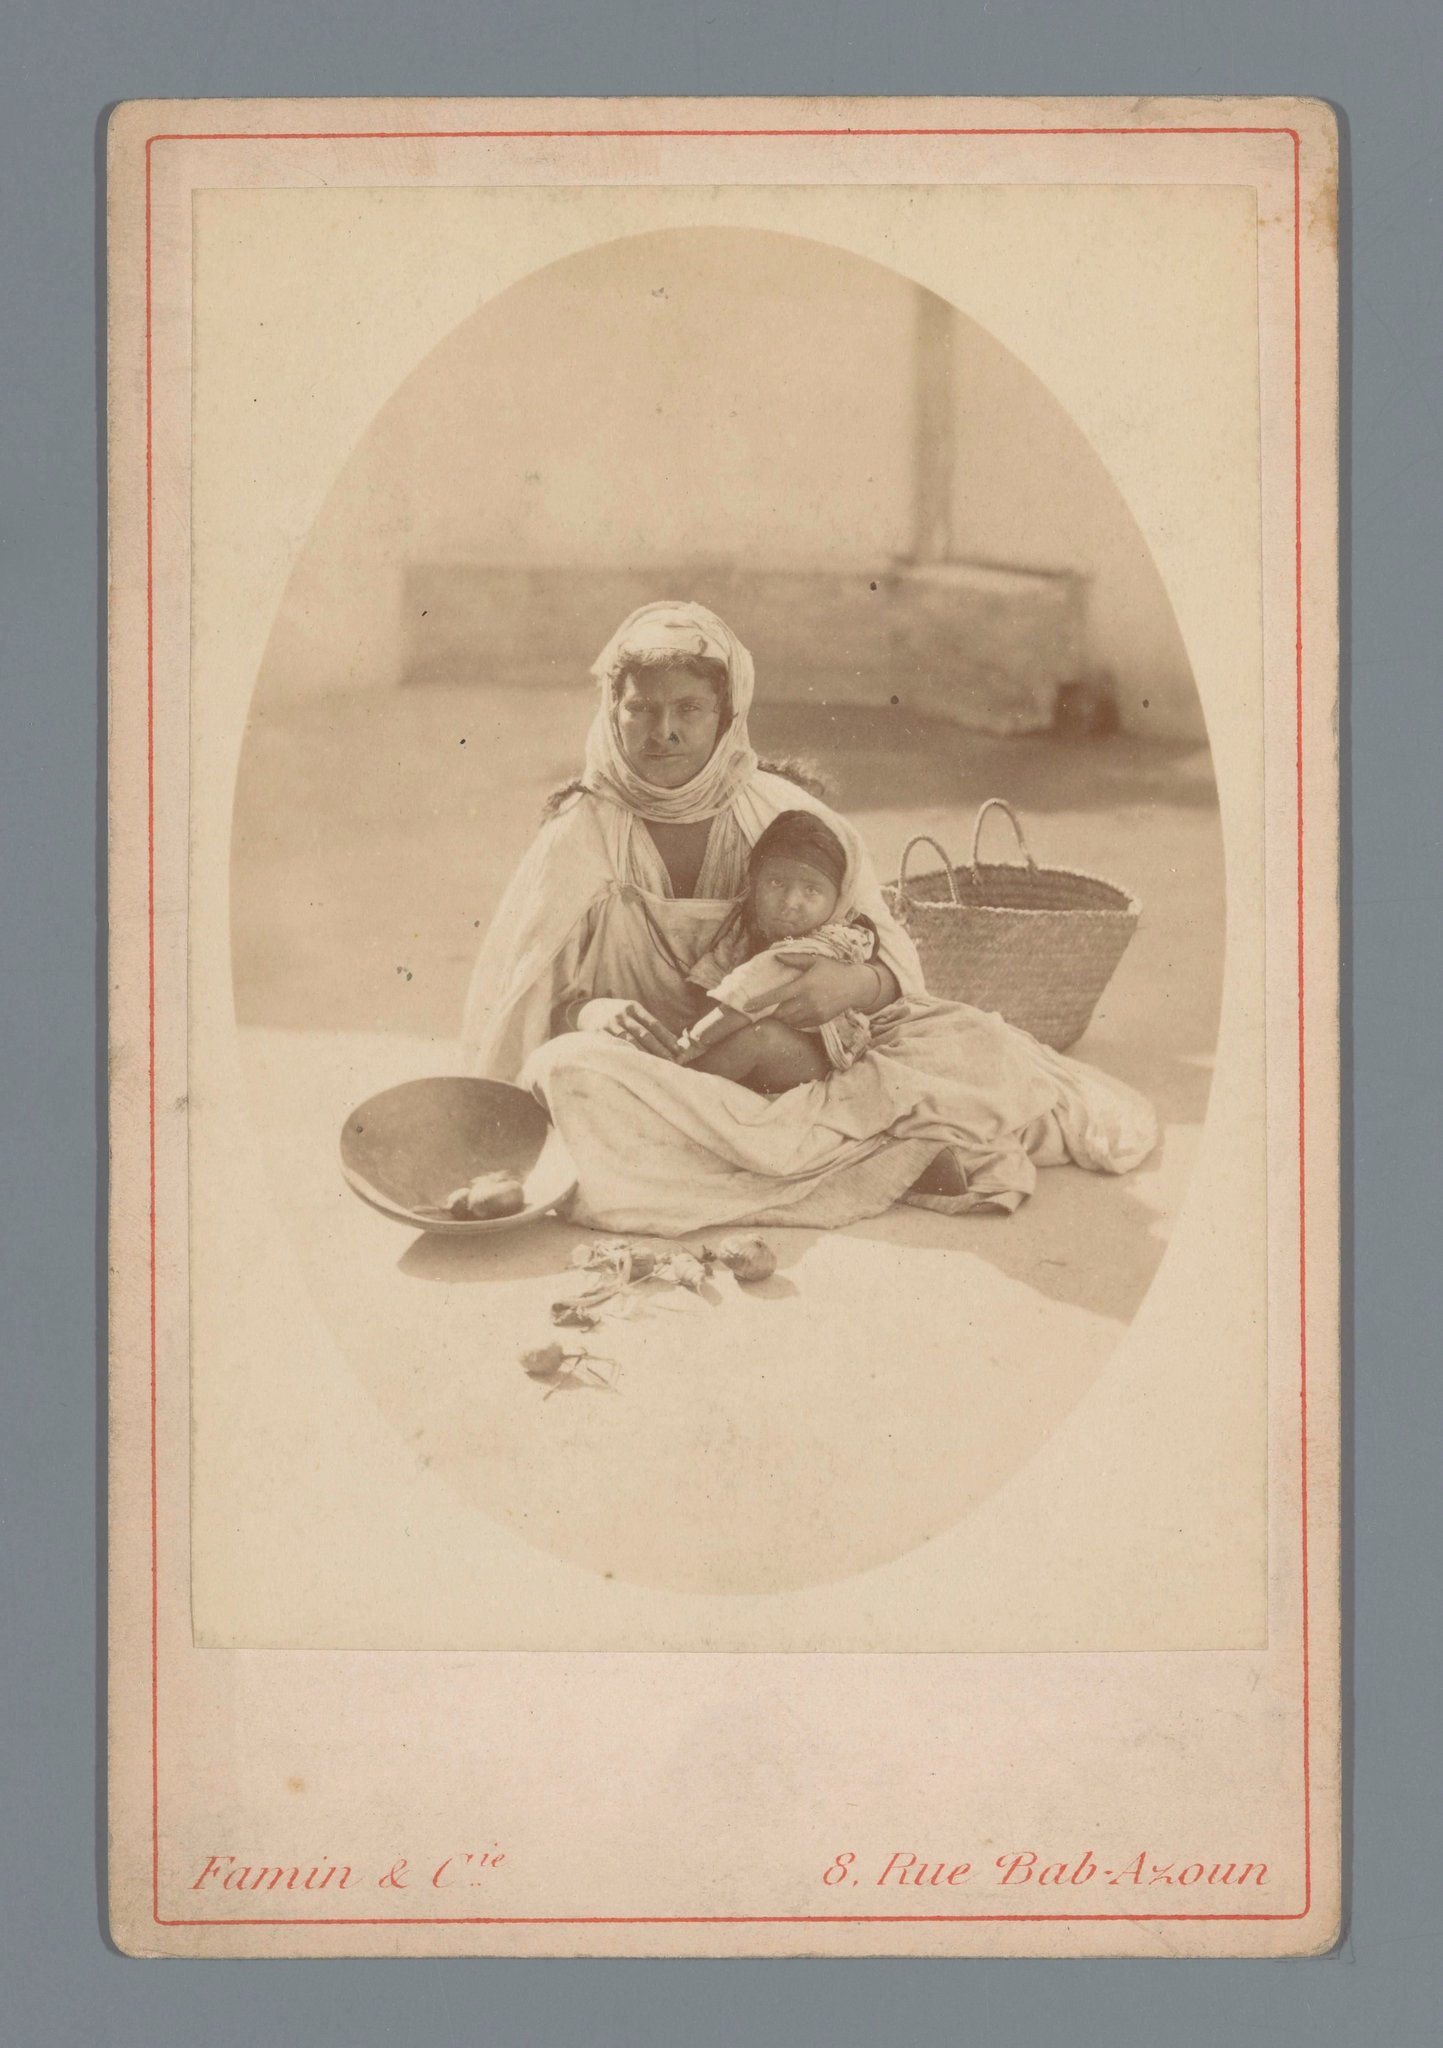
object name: cabinet photograph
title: Portret van een onbekende moeder en kind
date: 1863-1889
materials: cardboard, photographic support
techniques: albumen print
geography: algeria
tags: anonymous historical person portrayed, mother and baby or young child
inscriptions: inscription: ‘Alger/ 8, Rue Bab-Azoun, 8’, inscription: ‘femme et enfant/ Rabyb’, inscription: ‘8, Rue Bab-Azoun’